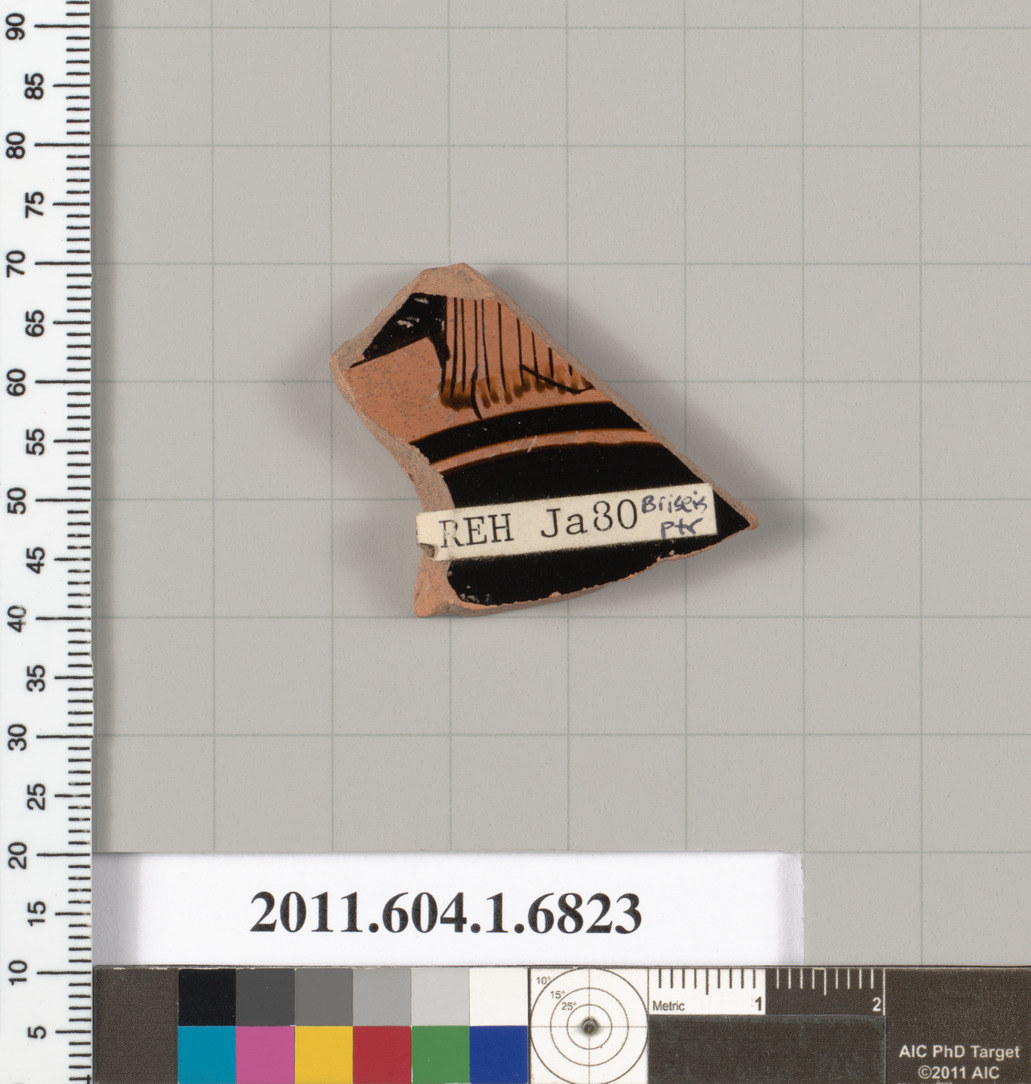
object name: kylix fragment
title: Terracotta fragment of a kylix (drinking cup)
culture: greek, attic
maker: briseis painter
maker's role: artist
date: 480-470 BCE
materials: terracotta